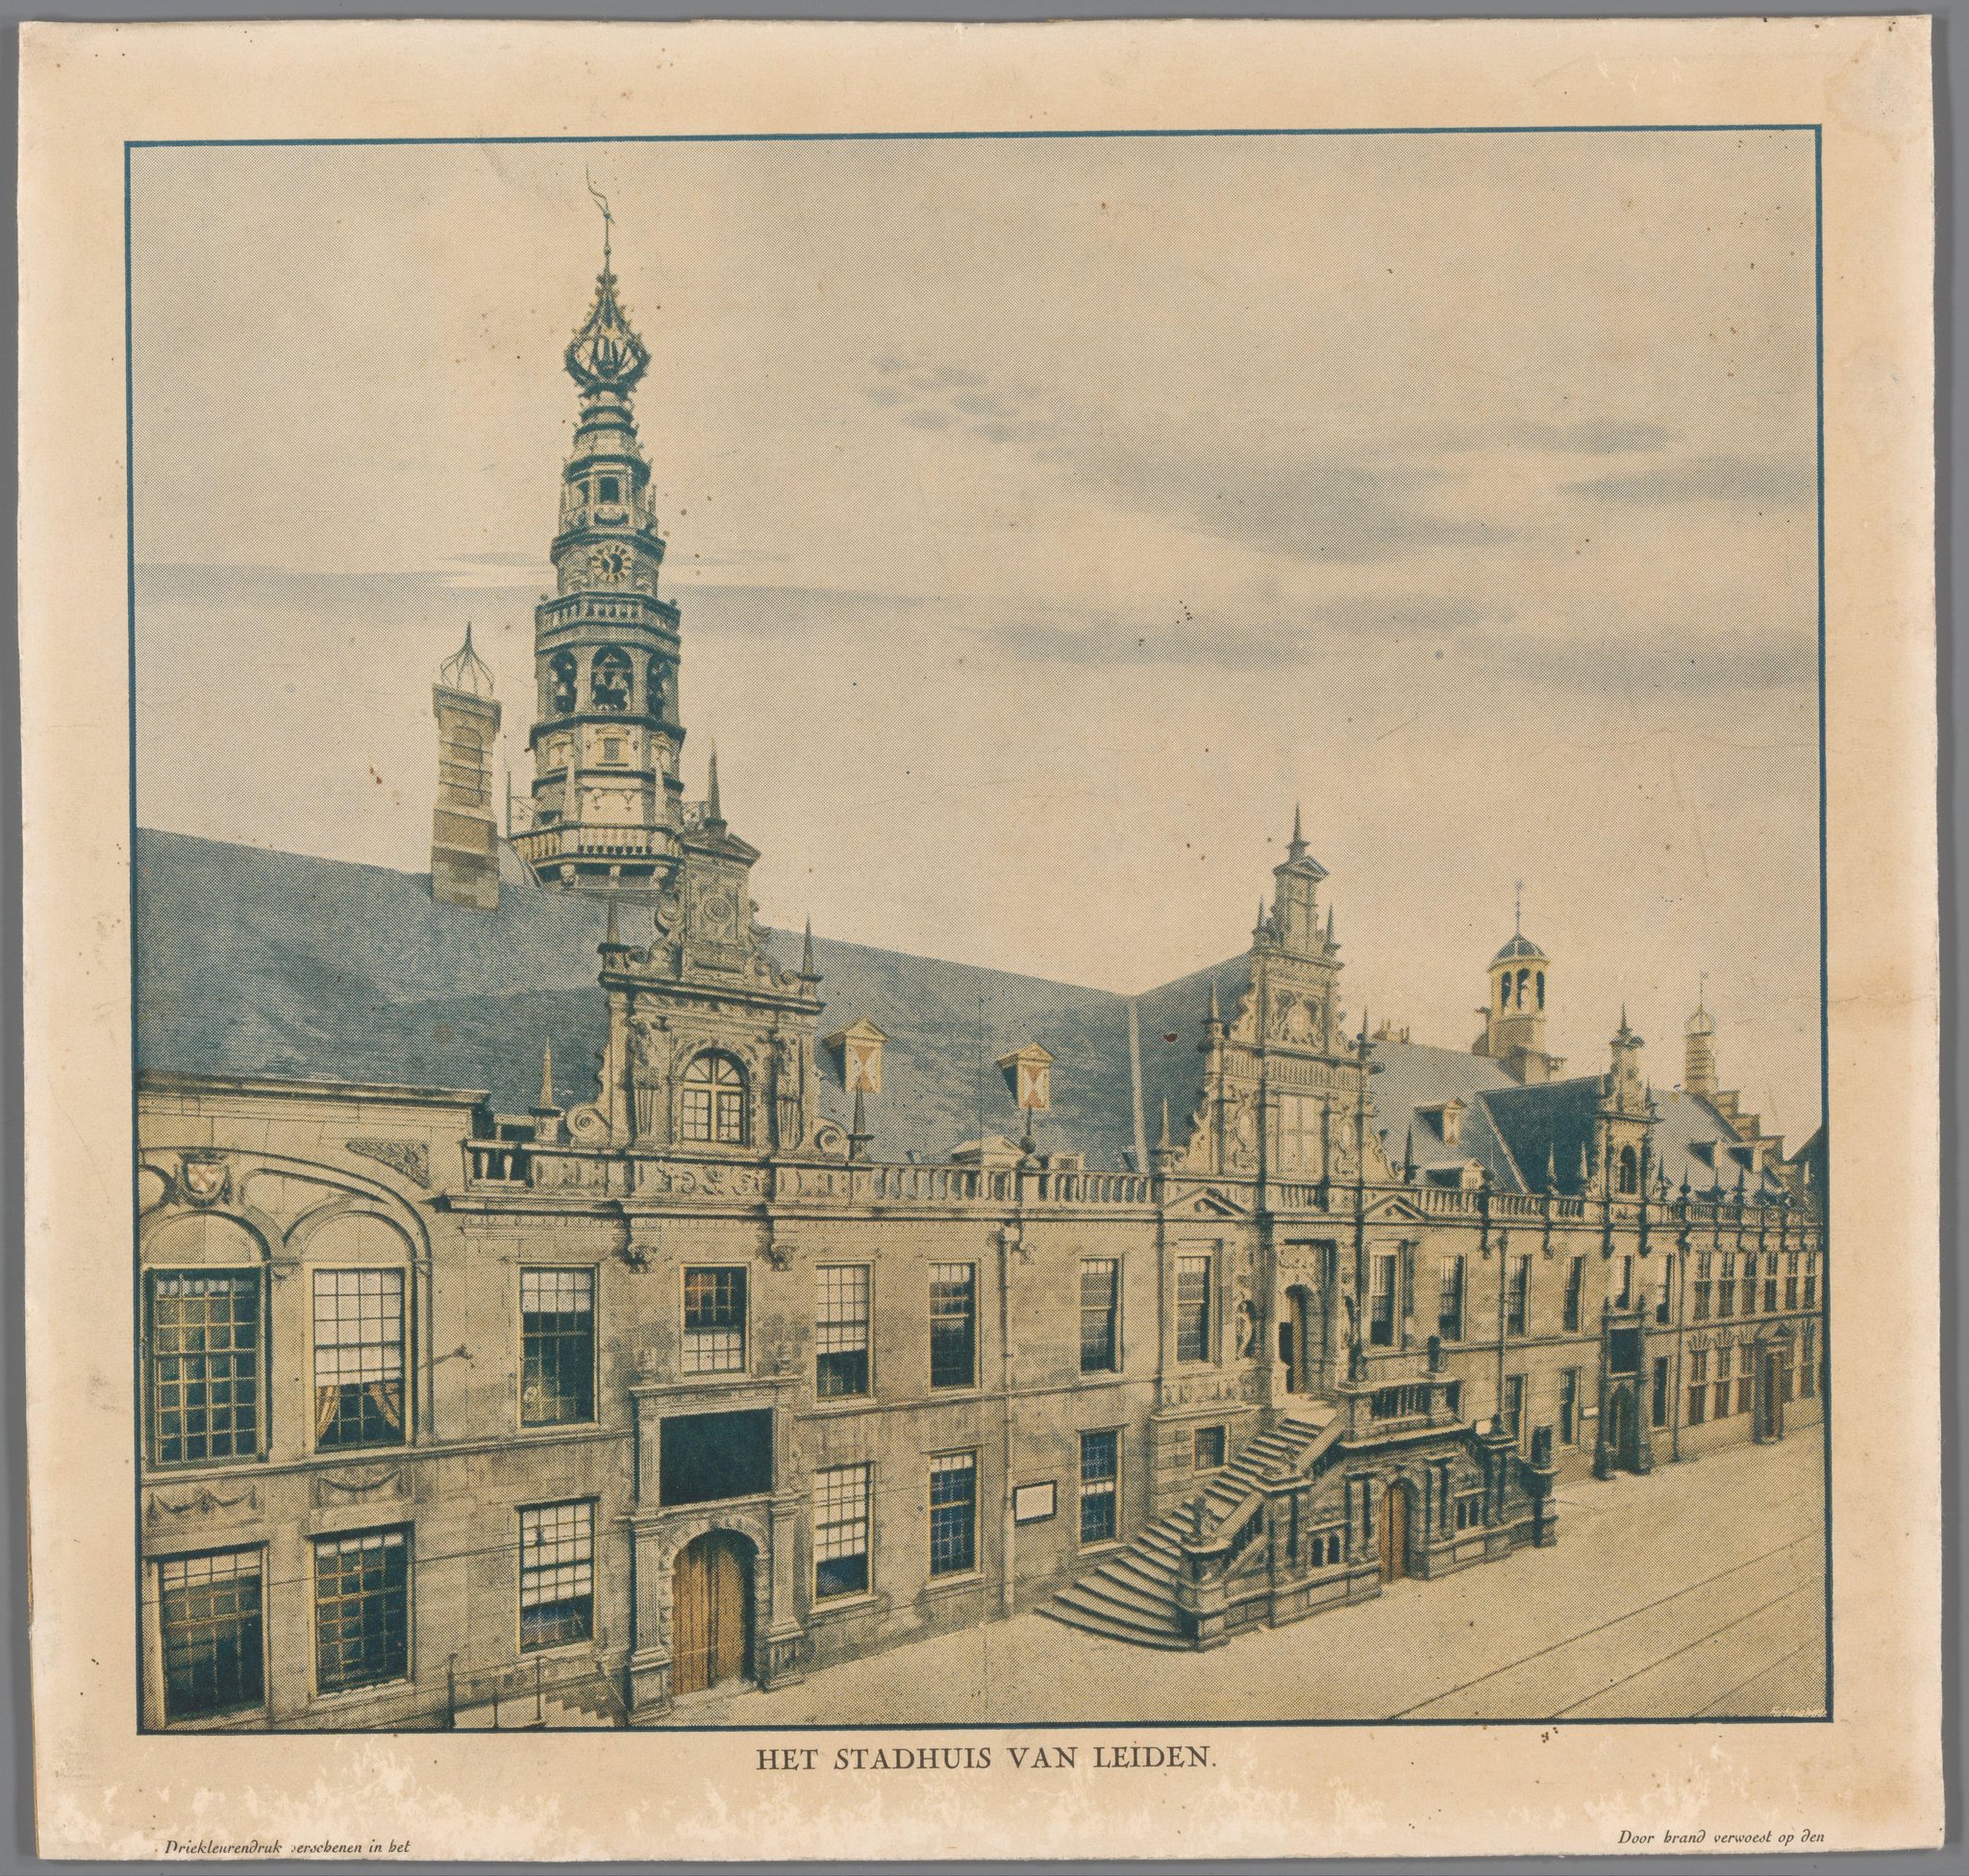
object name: photomechanical print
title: Gezicht op het stadhuis van Leiden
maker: Anonymous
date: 1929-1935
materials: cardboard, paper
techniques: color autotype, pasting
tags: townhall